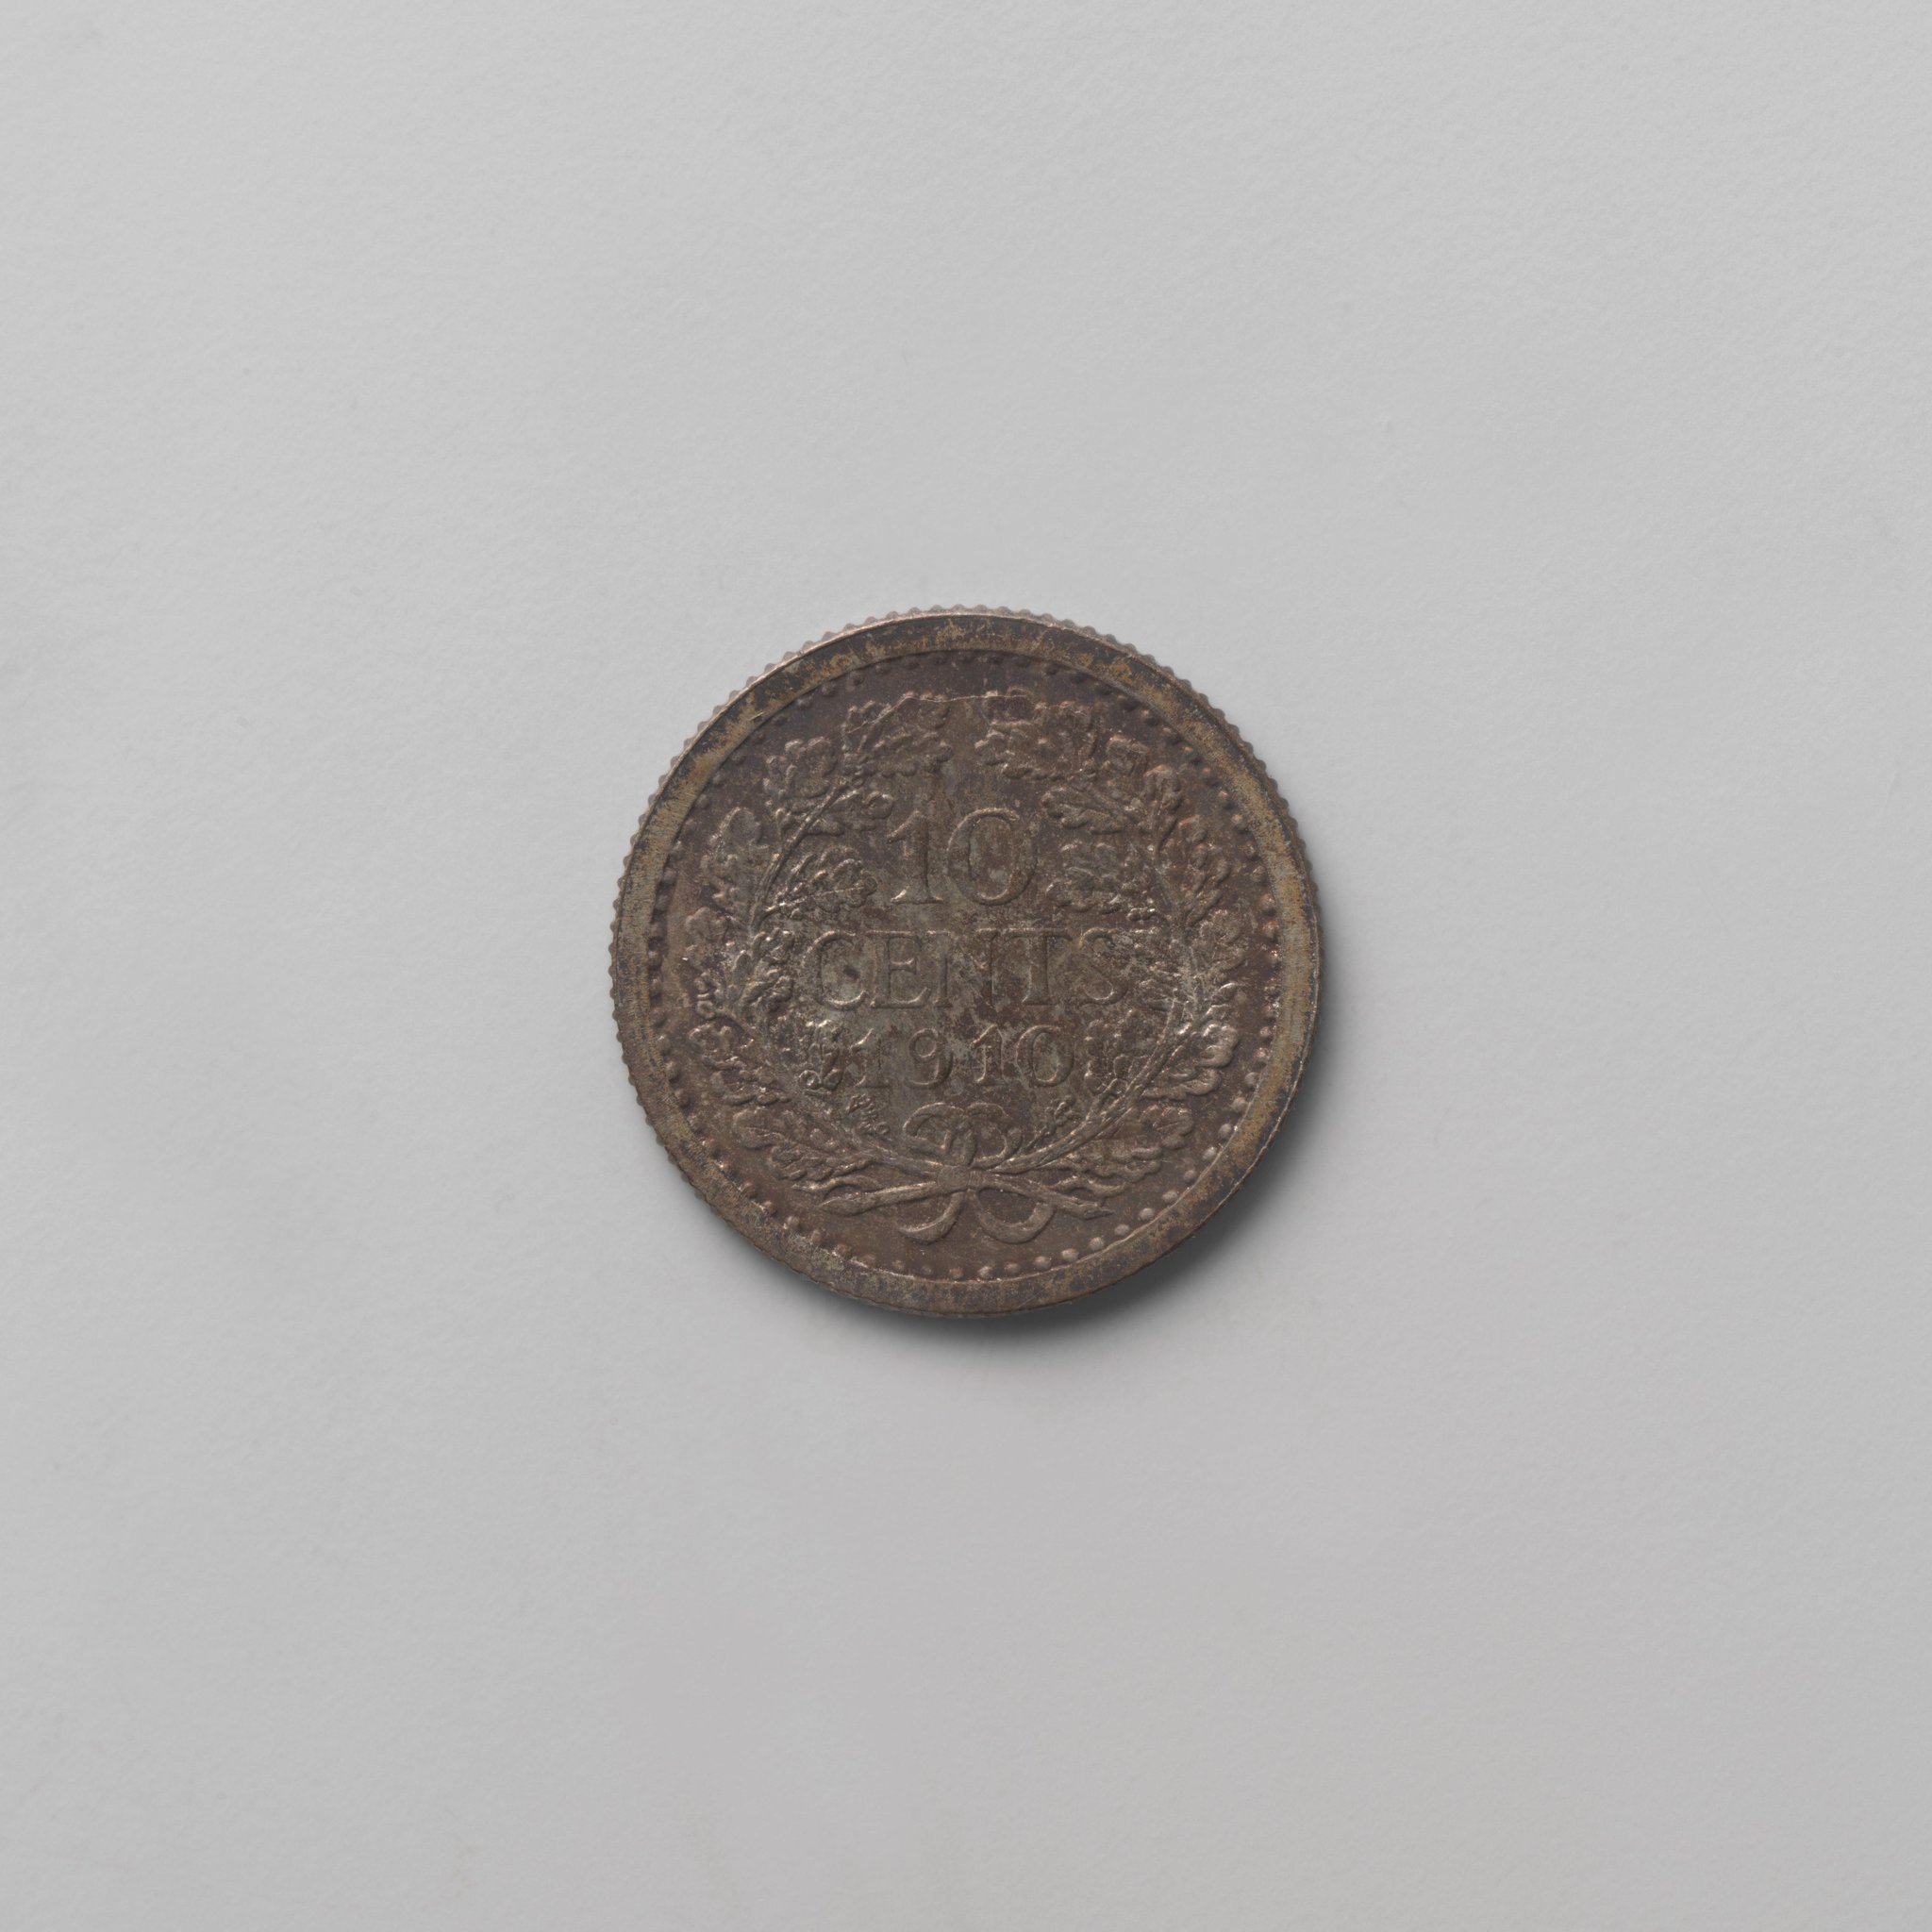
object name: coin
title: Nederlandse10 cent,1910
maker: wilhelmina of the netherlands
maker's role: print maker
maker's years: 1880-1962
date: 1910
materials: silver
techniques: striking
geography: utrecht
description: Zilveren munt. Voorzijde: gedrapeerd borstbeeld naar links. Keerzijde: binnen twee samengebonden eiketakken waarde-aanduiding 10 cents en jaartal. Kartelrand.